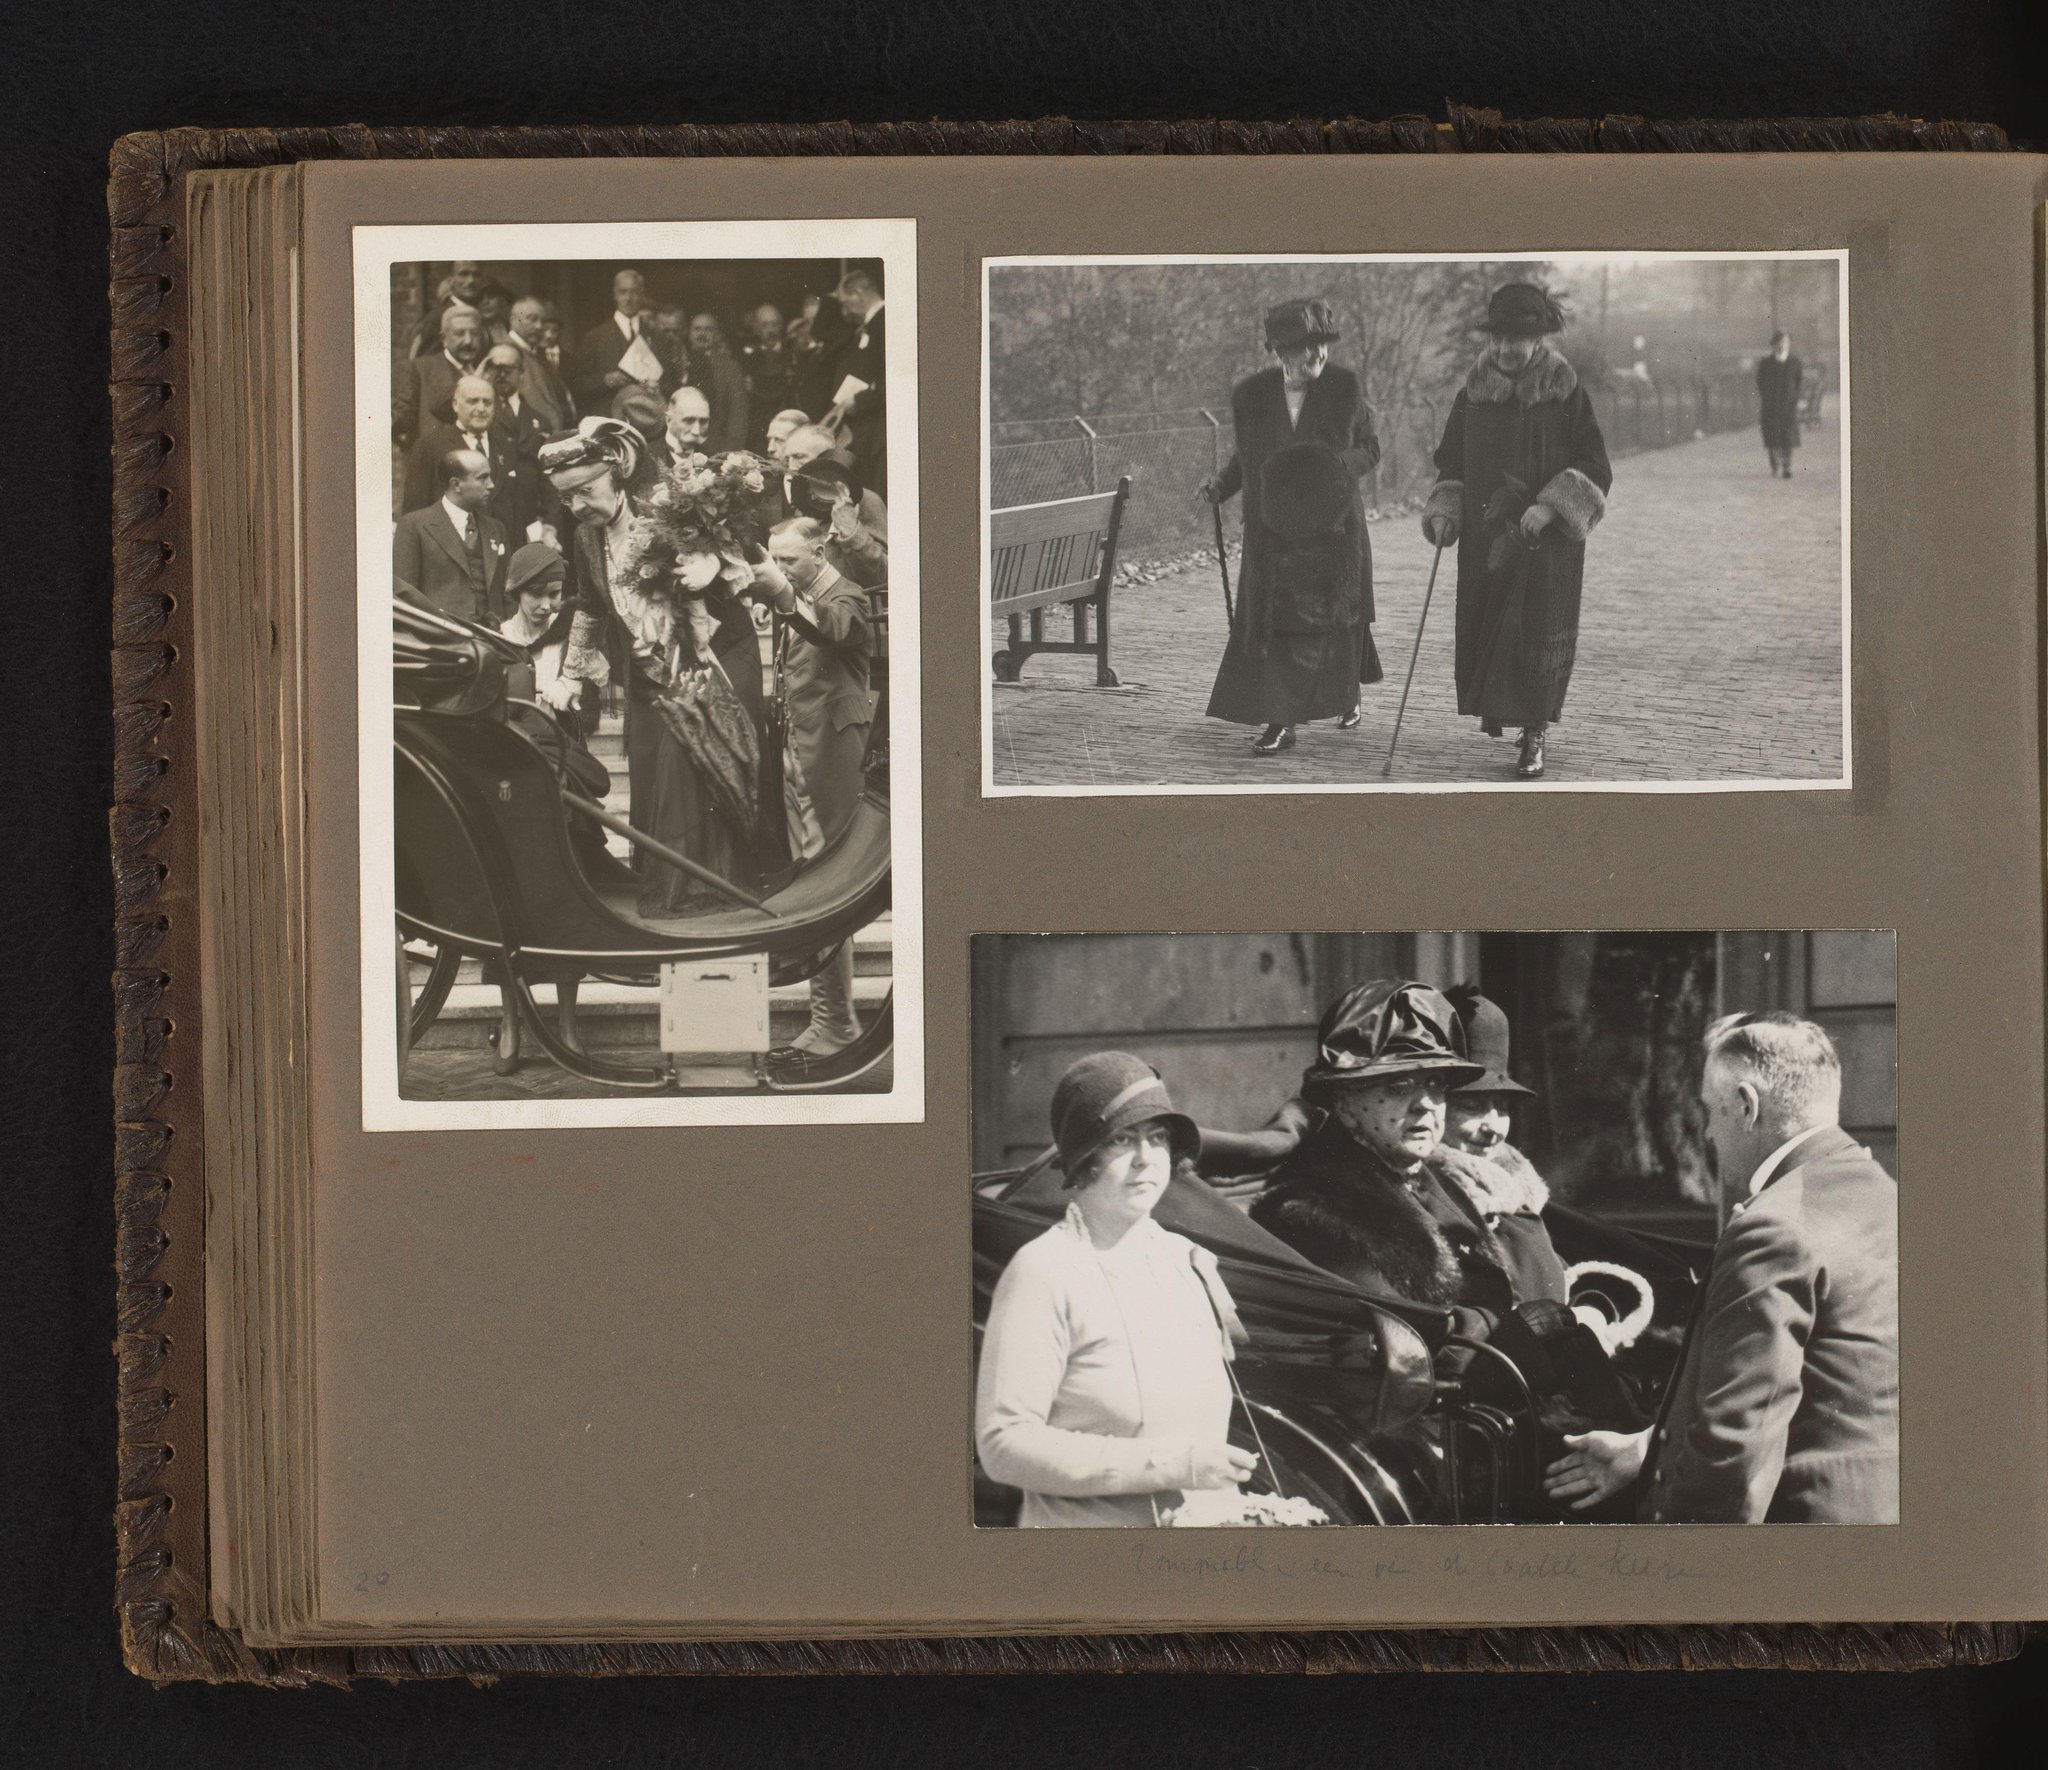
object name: photograph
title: Drie foto's van koningin-moeder Emma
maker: Anonymous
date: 1930-1934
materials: paper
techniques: gelatin silver print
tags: emma (queen consort of the netherlands), old woman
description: Deze foto's maken deel uit van een album.